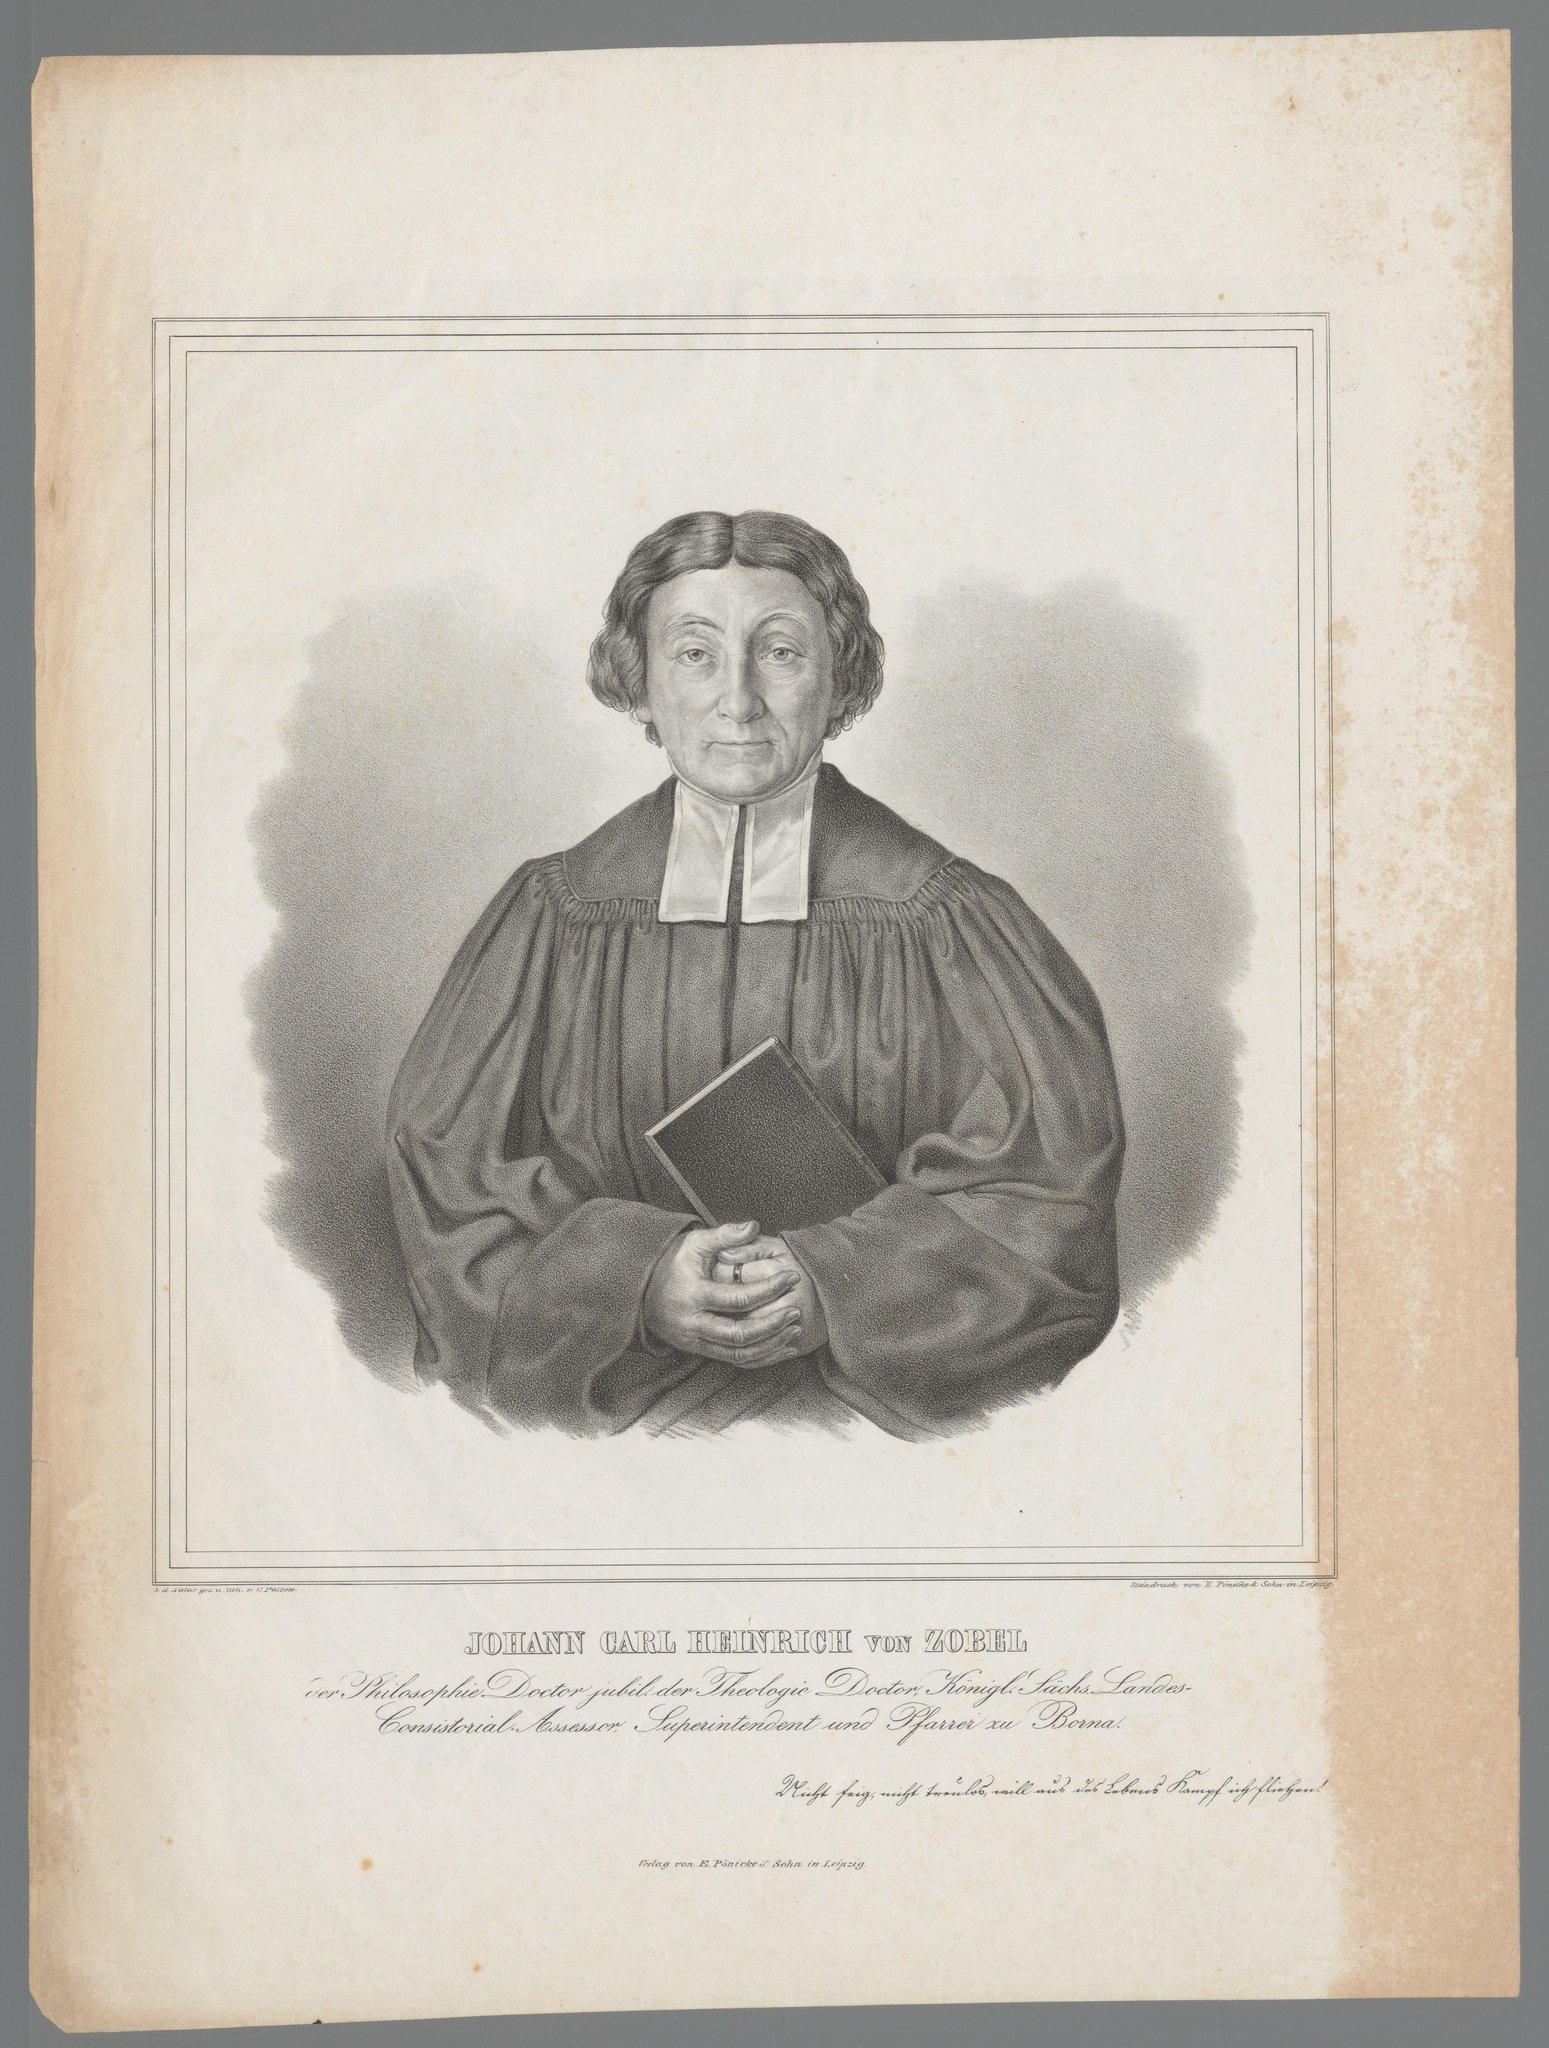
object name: print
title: Johann Carl Heinrich von Zobel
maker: karl palzow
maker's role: print maker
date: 1820-1850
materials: paper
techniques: lithograph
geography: leipzig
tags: adult man, historical persons, book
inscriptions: collector's mark: Lugt 2228